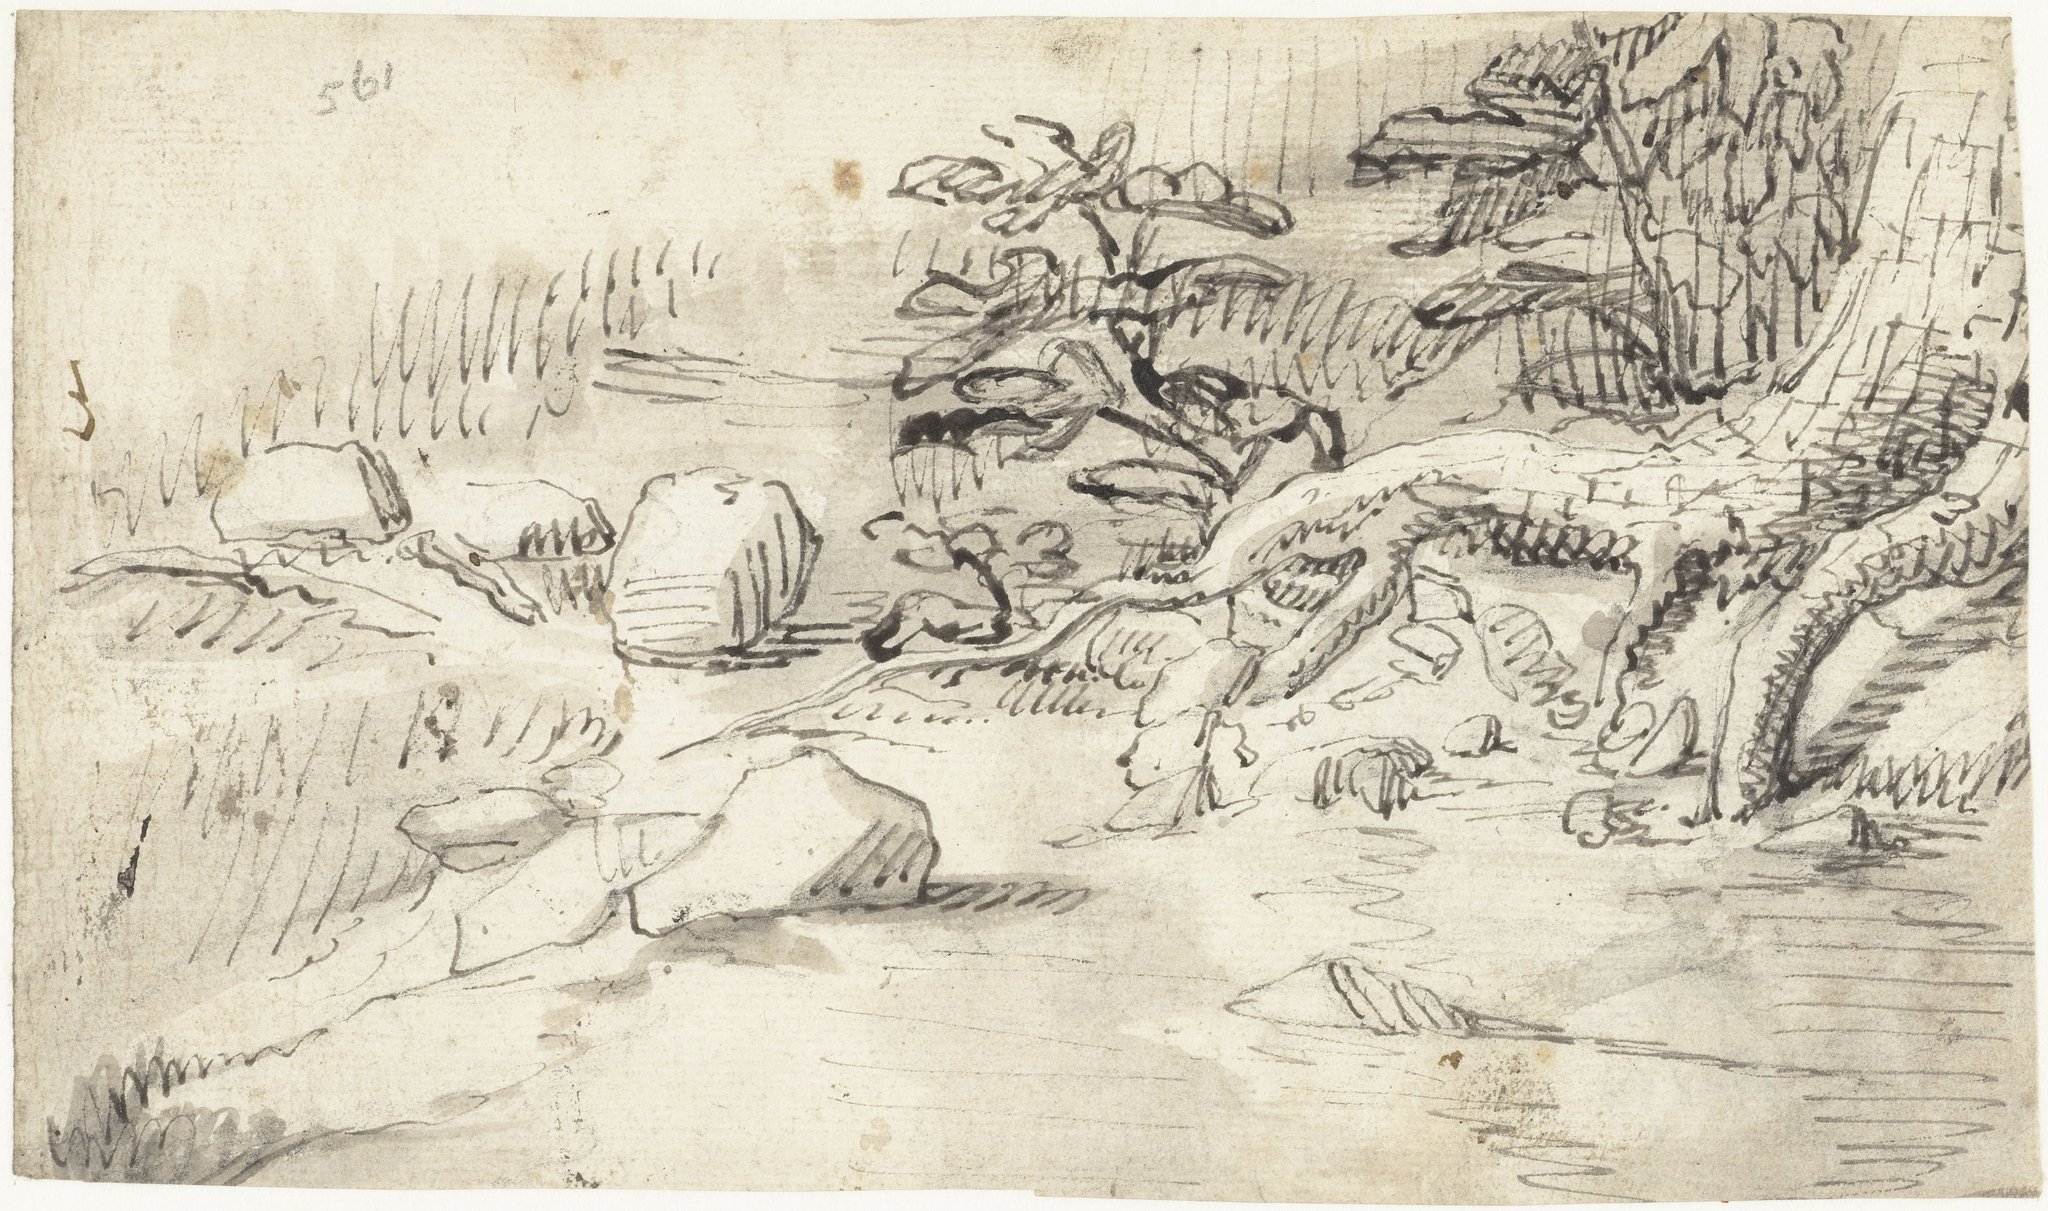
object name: drawing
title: Studie van de wortels van een boom bij een stroompje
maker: gerard ter borch (i)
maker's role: draughtsman, print maker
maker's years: 1584-1662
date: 1614-1616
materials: ink, paper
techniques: brush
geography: zwolle